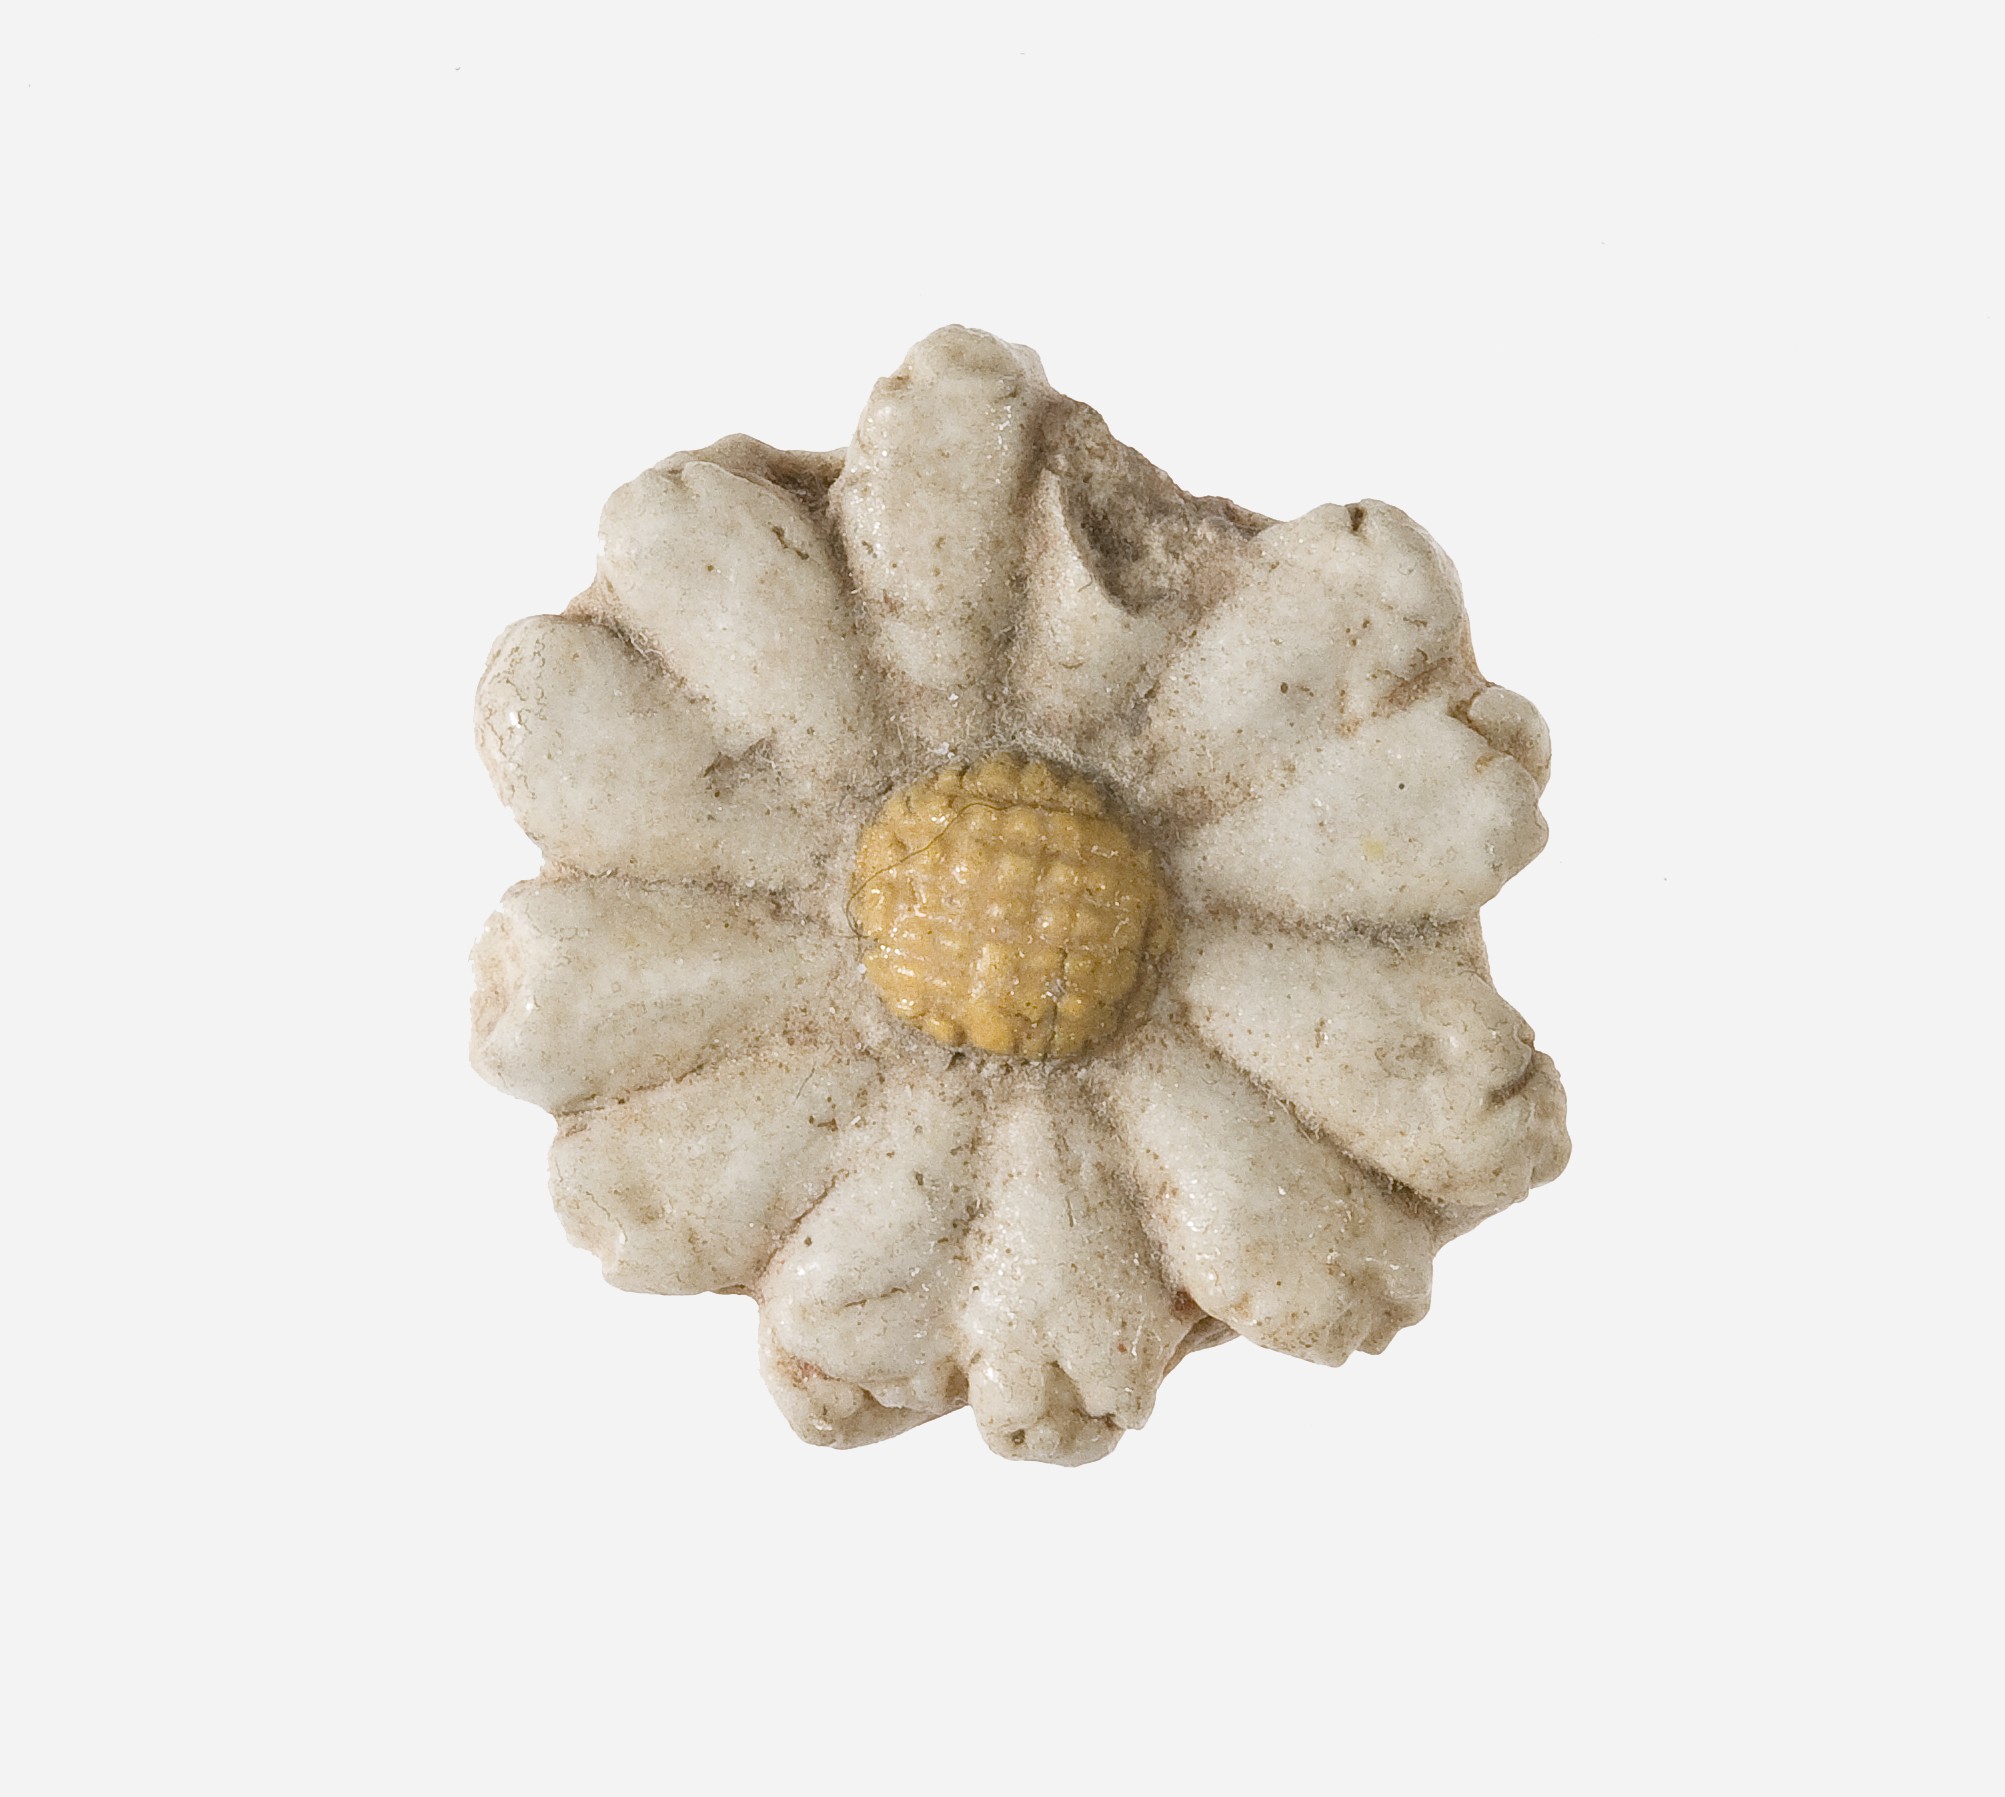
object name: pendant, daisy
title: Daisy Pendant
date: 1390-1352 BCE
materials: faience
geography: egypt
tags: daisies